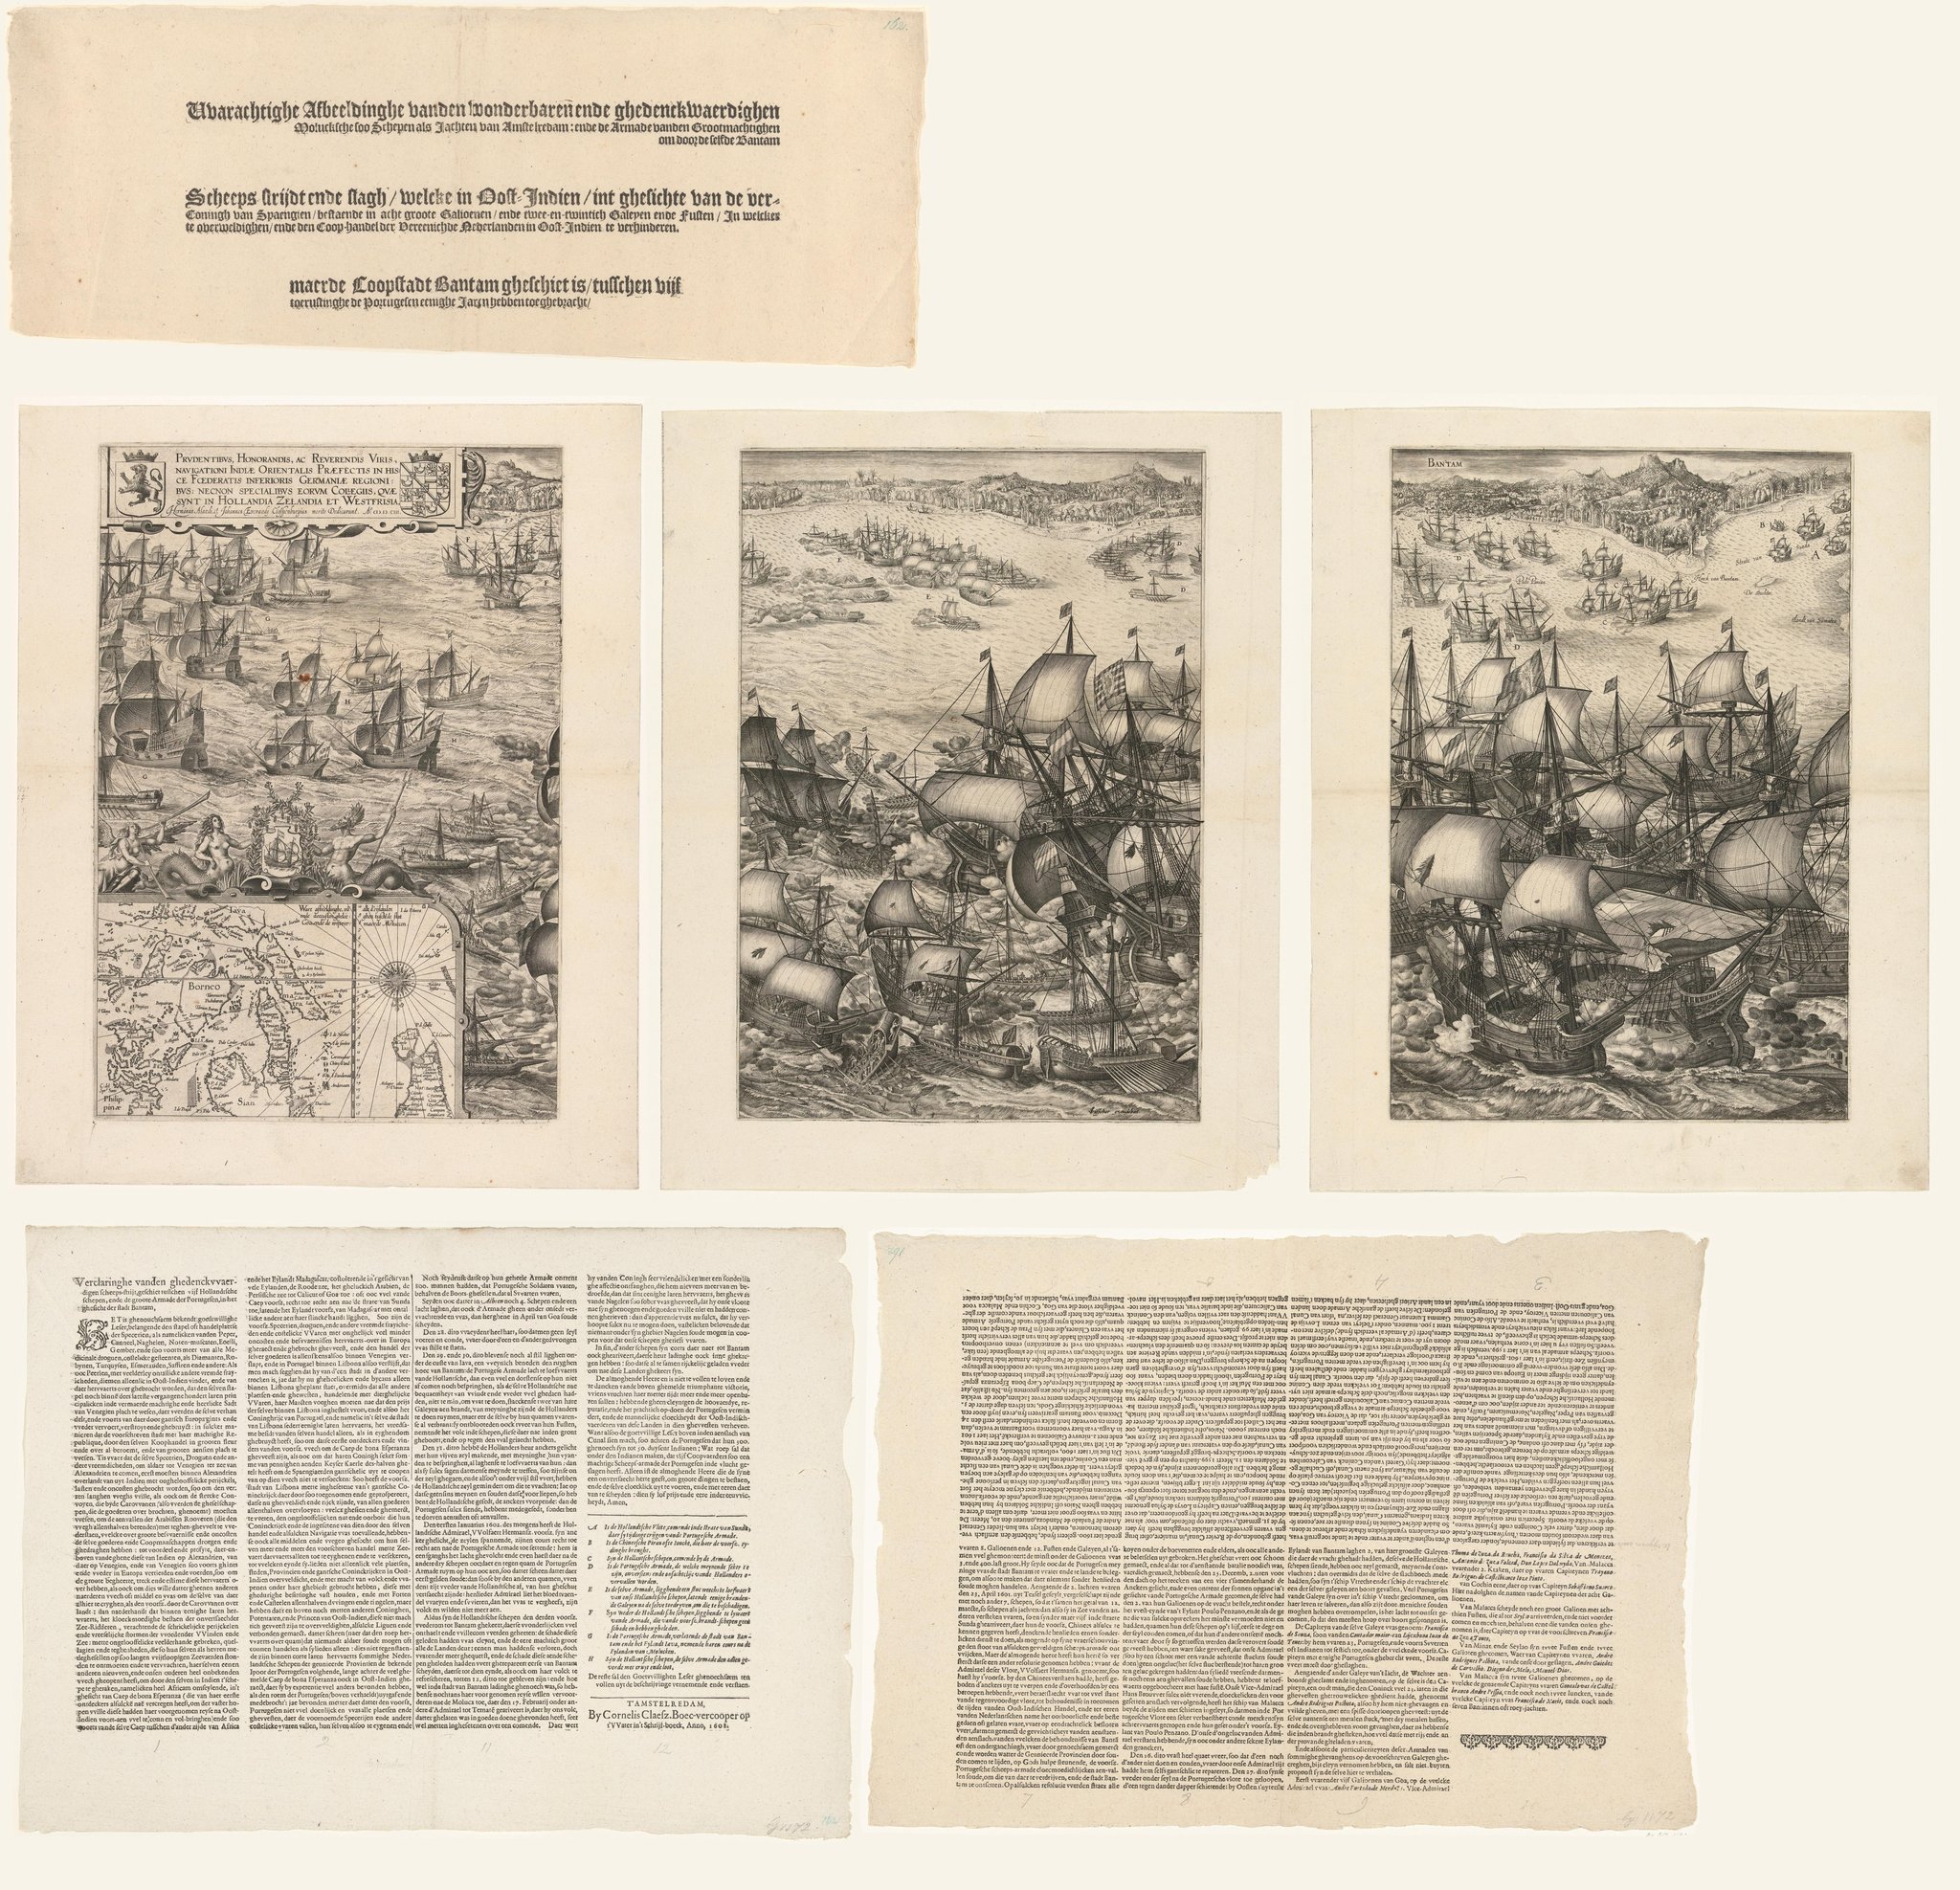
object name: print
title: Warachtighe Afbeeldinghe vanden wonderbaren ende ghedenckwaerdighen Scheeps-strijdt ende slagh / welcke in Oost-Indien / int ghesichte van de vermaerde Coopstadt Bantam gheschiet is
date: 1603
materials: paper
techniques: engraving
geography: northern netherlands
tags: maps of separate countries or regions, battle (+ naval force), sri lanka, indonesia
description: Overwinning van de admiraal Wolfert Hermansz met vijf schepen op de Portugese vloot van dertig schepen in de zeeslag voor Bantam, 25-30 december 1601. Geheel bestaande uit een grote voorstelling op drie bladen met bijbehorende tekstbladen en titel. Met titel en tekstbladen om los te knippen en te monteren.